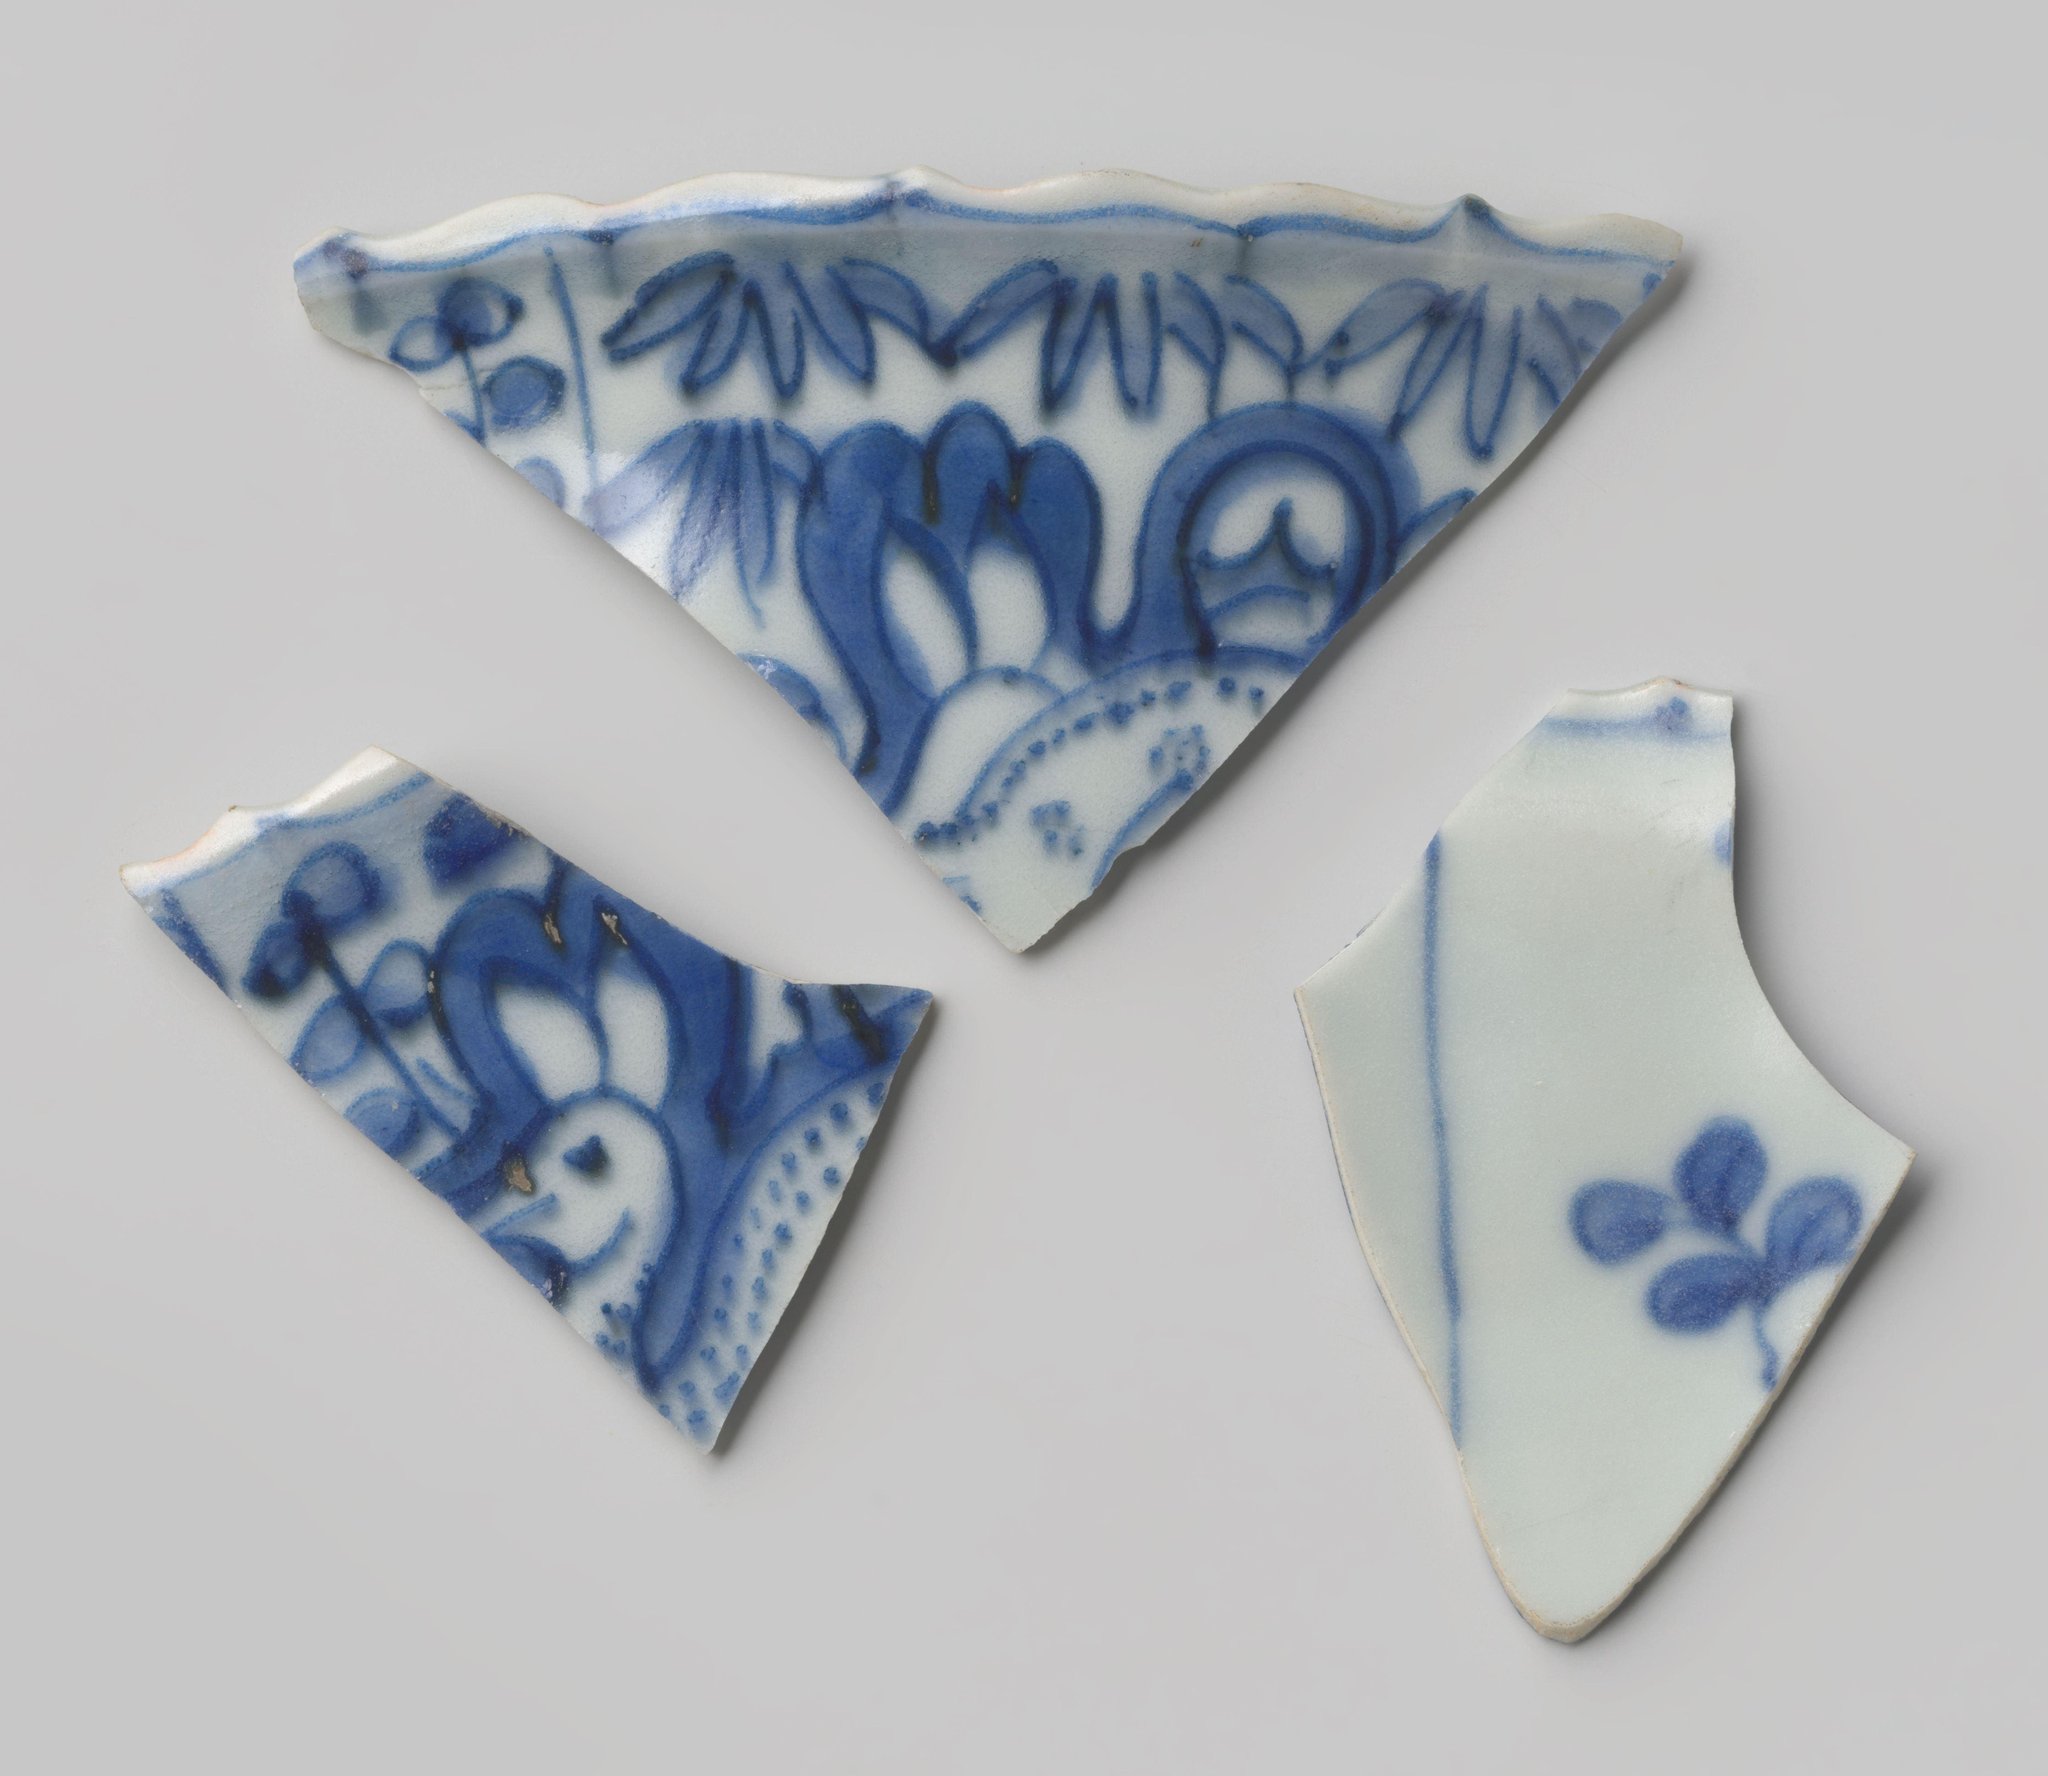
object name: bowl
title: Scherven van een kom uit V.O.C.-schip de 'Witte Leeuw'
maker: Anonymous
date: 1613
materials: bone china, porcelain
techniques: painted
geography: jingdezhen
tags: verenigde oostindische compagnie, sint-helena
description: Kom uit V.O.C.-schip de 'Witte Leeuw'. Scherven van een hoge kom gedecoreerd in onderglazuur blauw. De wand is ingedeeld in velden, onderling gescheiden door een smalle verticale lijn. In de velden een gestileerd hert, uitgespaard in wit tegen een achtergrond van blauwe blad en munt-motieven.